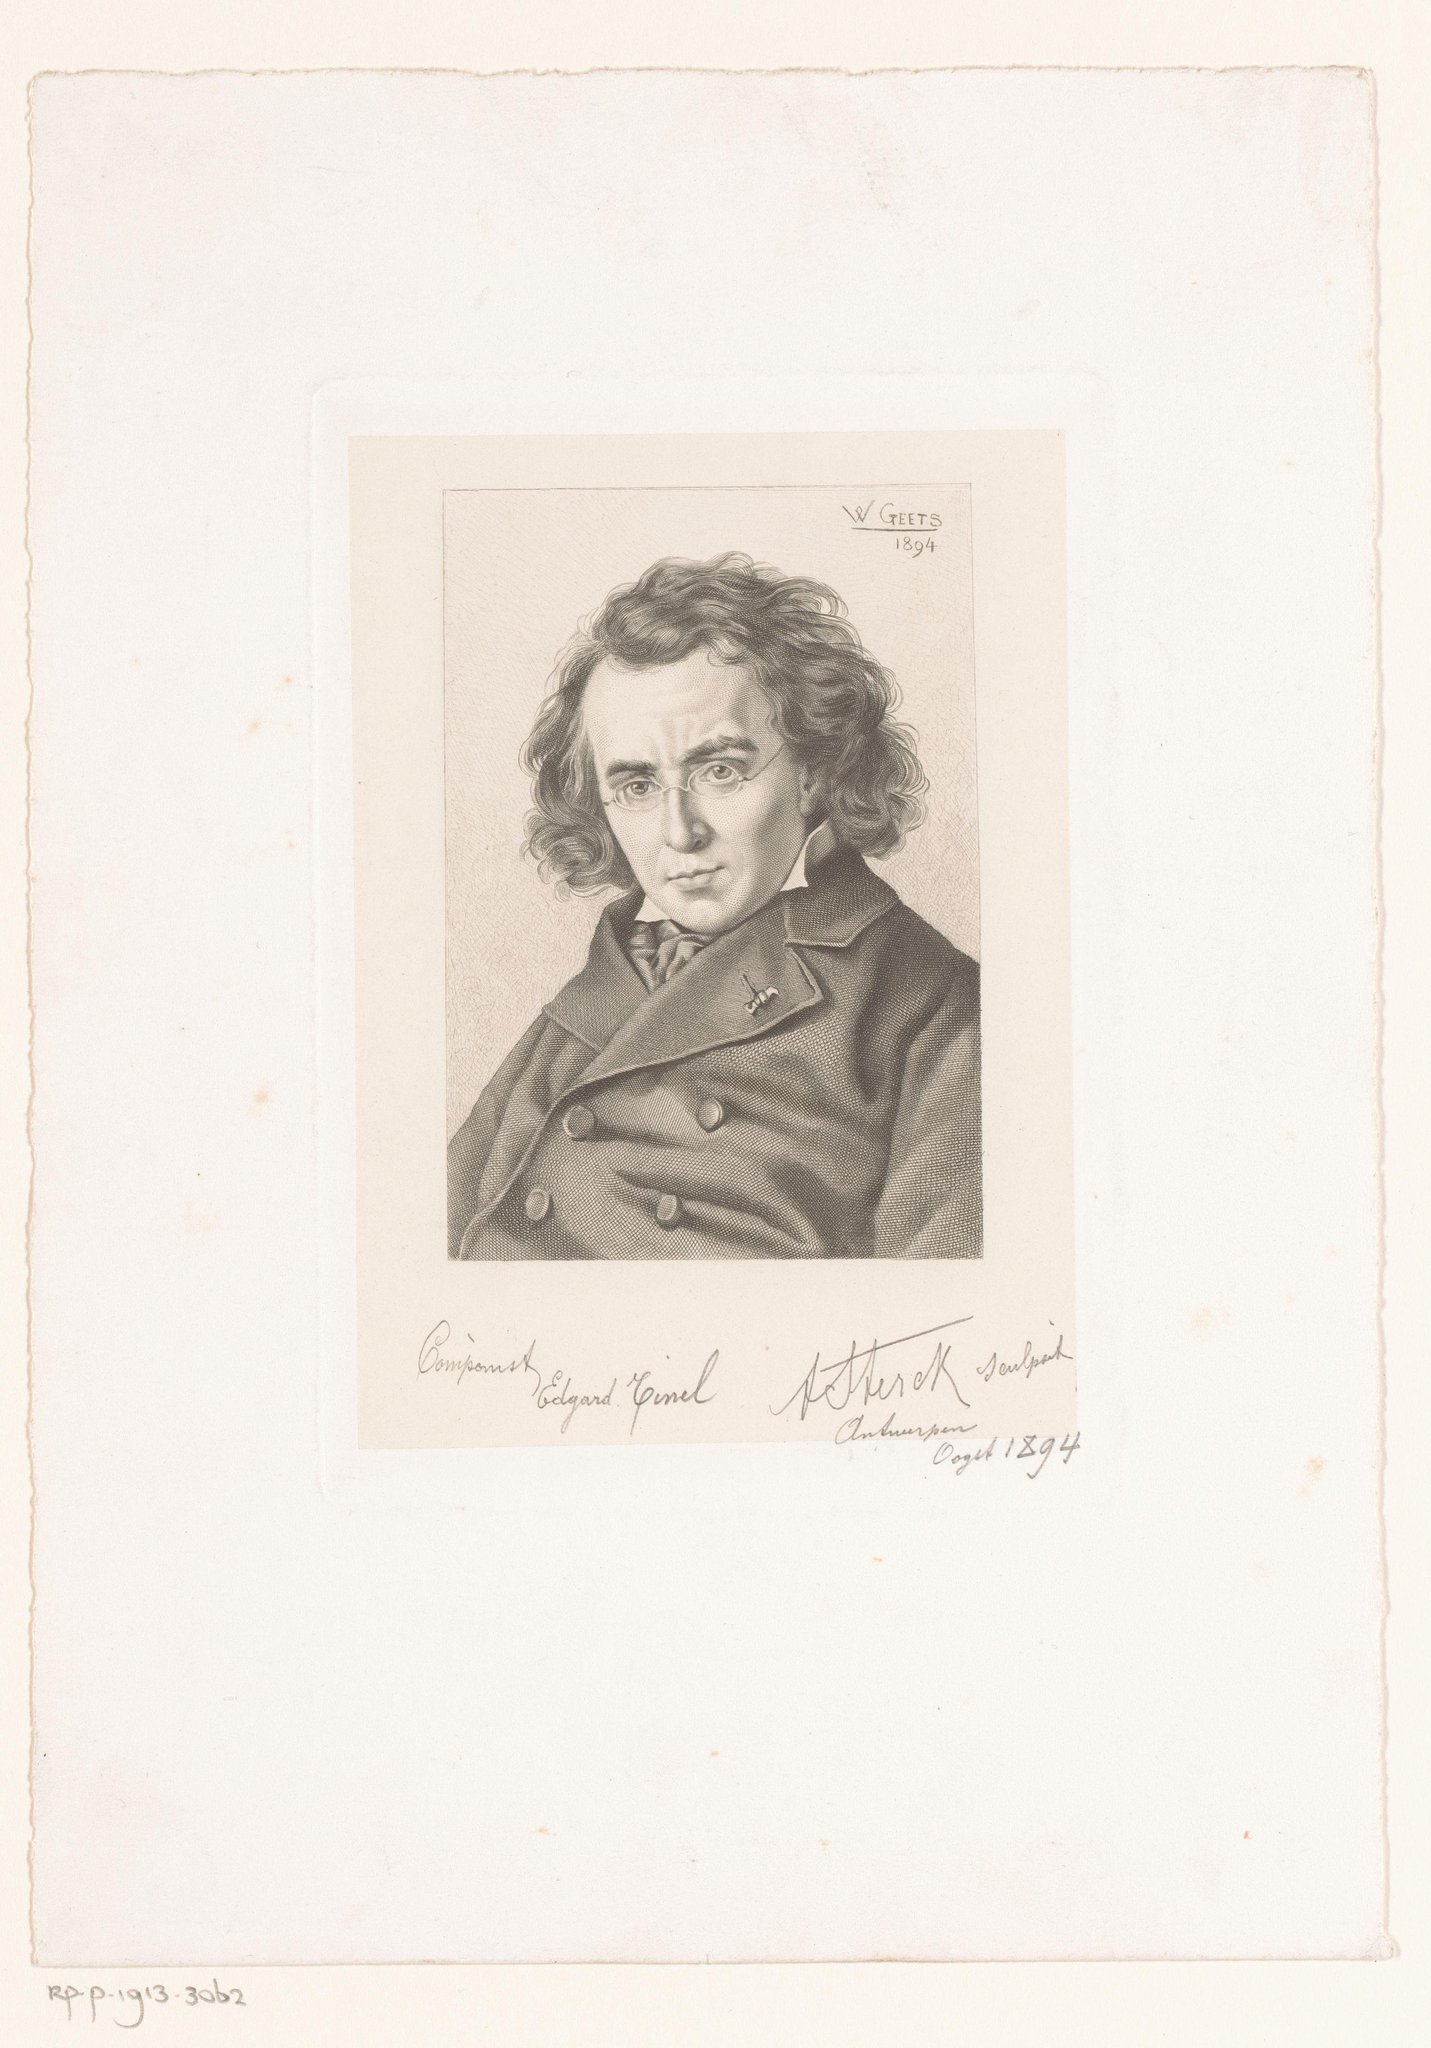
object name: print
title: Portret van Edgar Tinel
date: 1894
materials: paper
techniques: engraving, etching, intaglio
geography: antwerp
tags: brussels, historical persons, portrait of composer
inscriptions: collector's mark: Lugt 2228